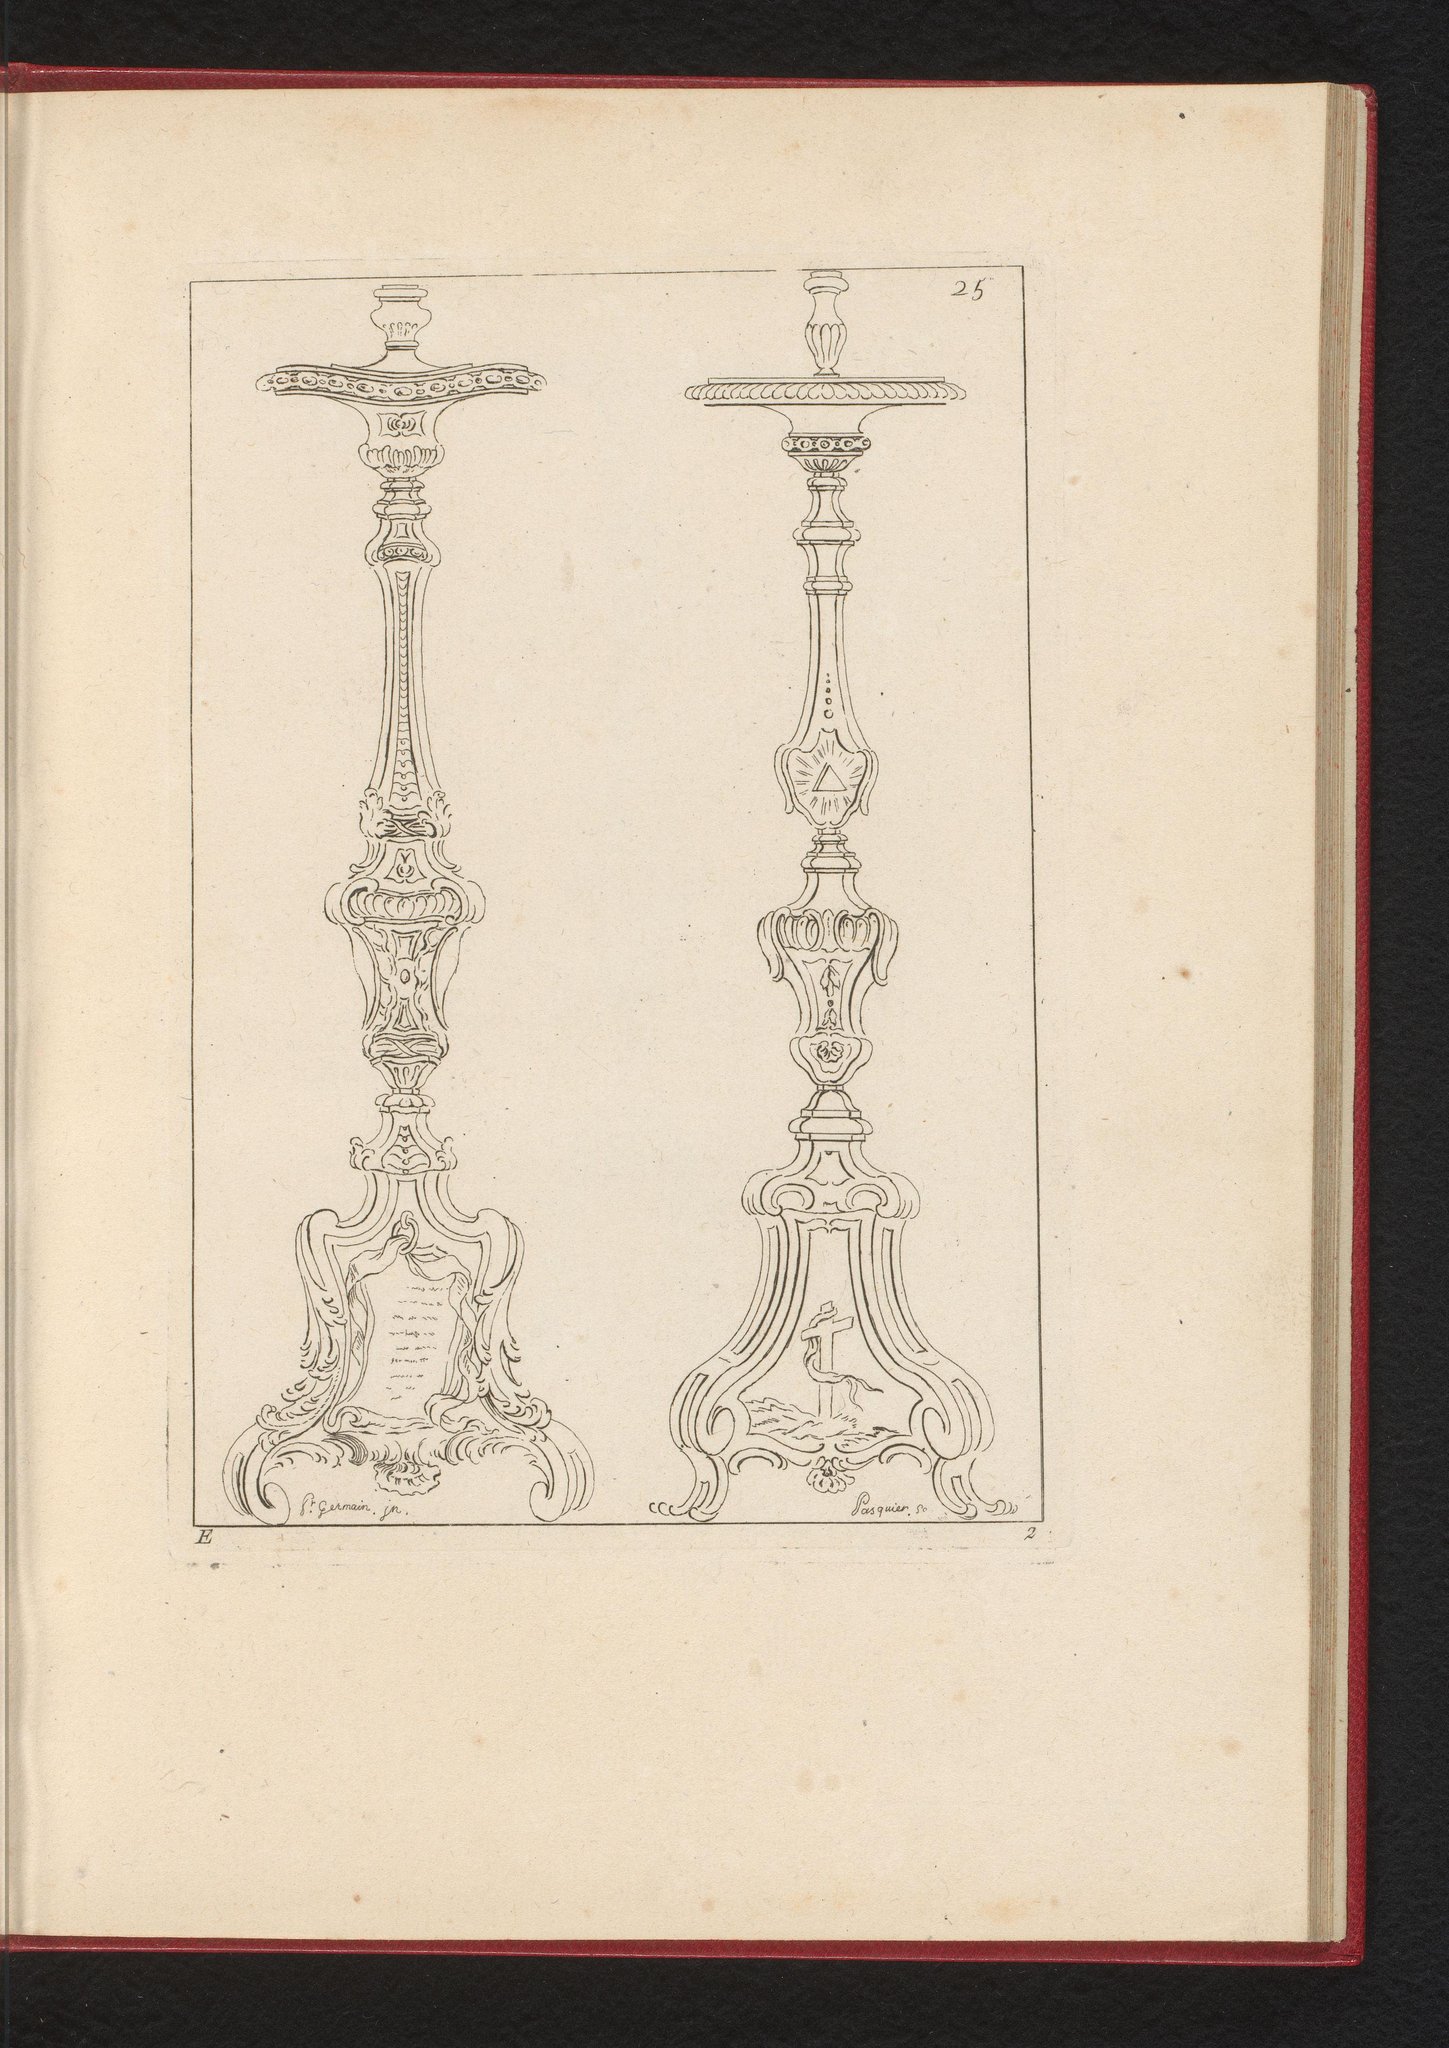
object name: album leaf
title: Ontwerp voor twee altaarkandelaars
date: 1748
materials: paper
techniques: etching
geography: paris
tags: candlesticks and candles, e.g. easter-candlestick, jeweller, goldsmith, silversmith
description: Een aantal van de objecten in deze reeks heeft een eigen ondertitel, die verwijst naar genummerde 'cahiers' (afleveringen) waarin de prenten werden uitgegeven. Het is onduidelijk welke objecten recies bij welke aflevering horen. Daarom is die ondertitel enkel verwerkt bij de prent waarop die voorkomt.